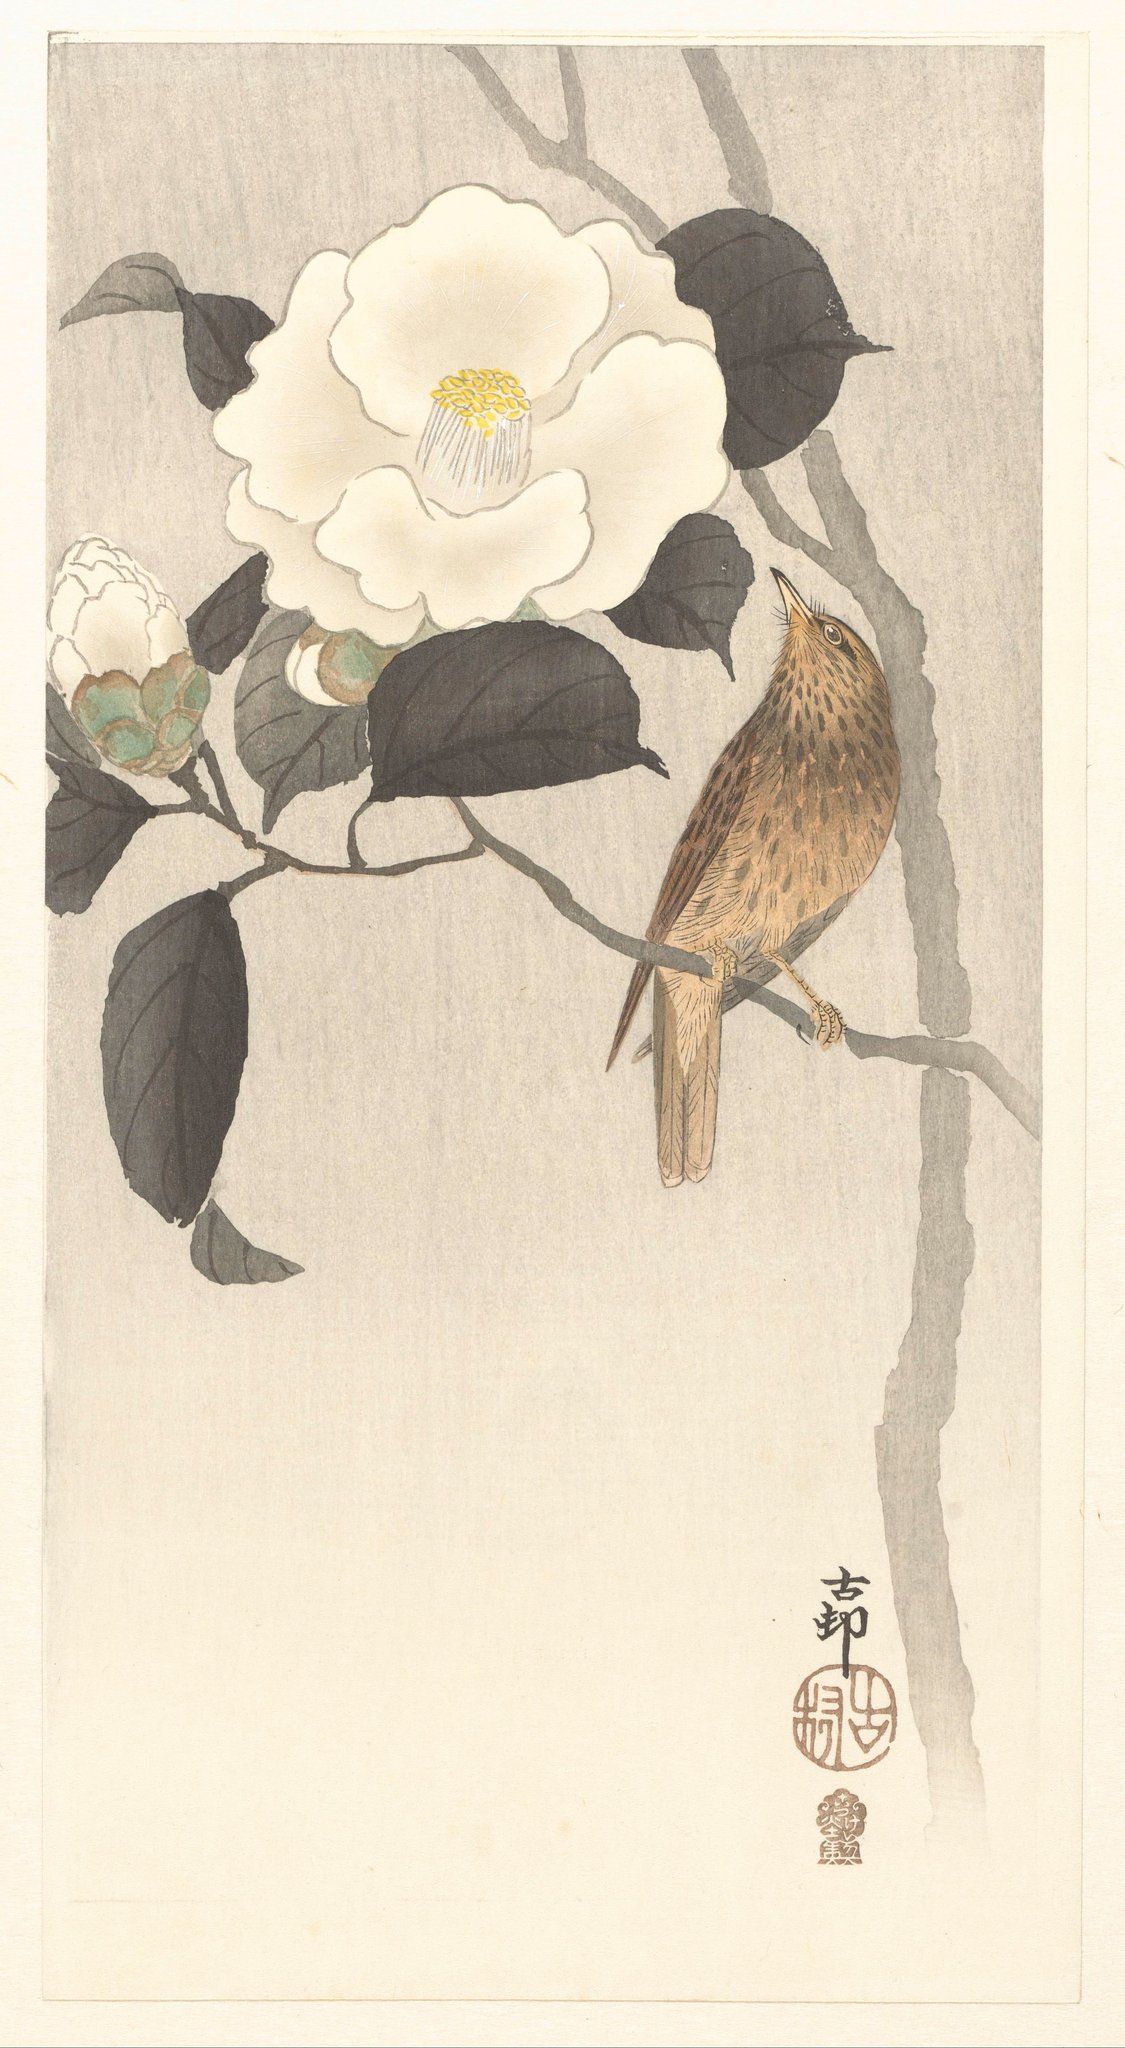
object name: print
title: Zangvogel en bloeiende camellia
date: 1900-1910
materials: paper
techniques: woodcut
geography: japan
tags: flowers, song-birds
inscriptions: collector's mark: Lugt 2228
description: Vogeltje op tak van bloeiende witte camellia.